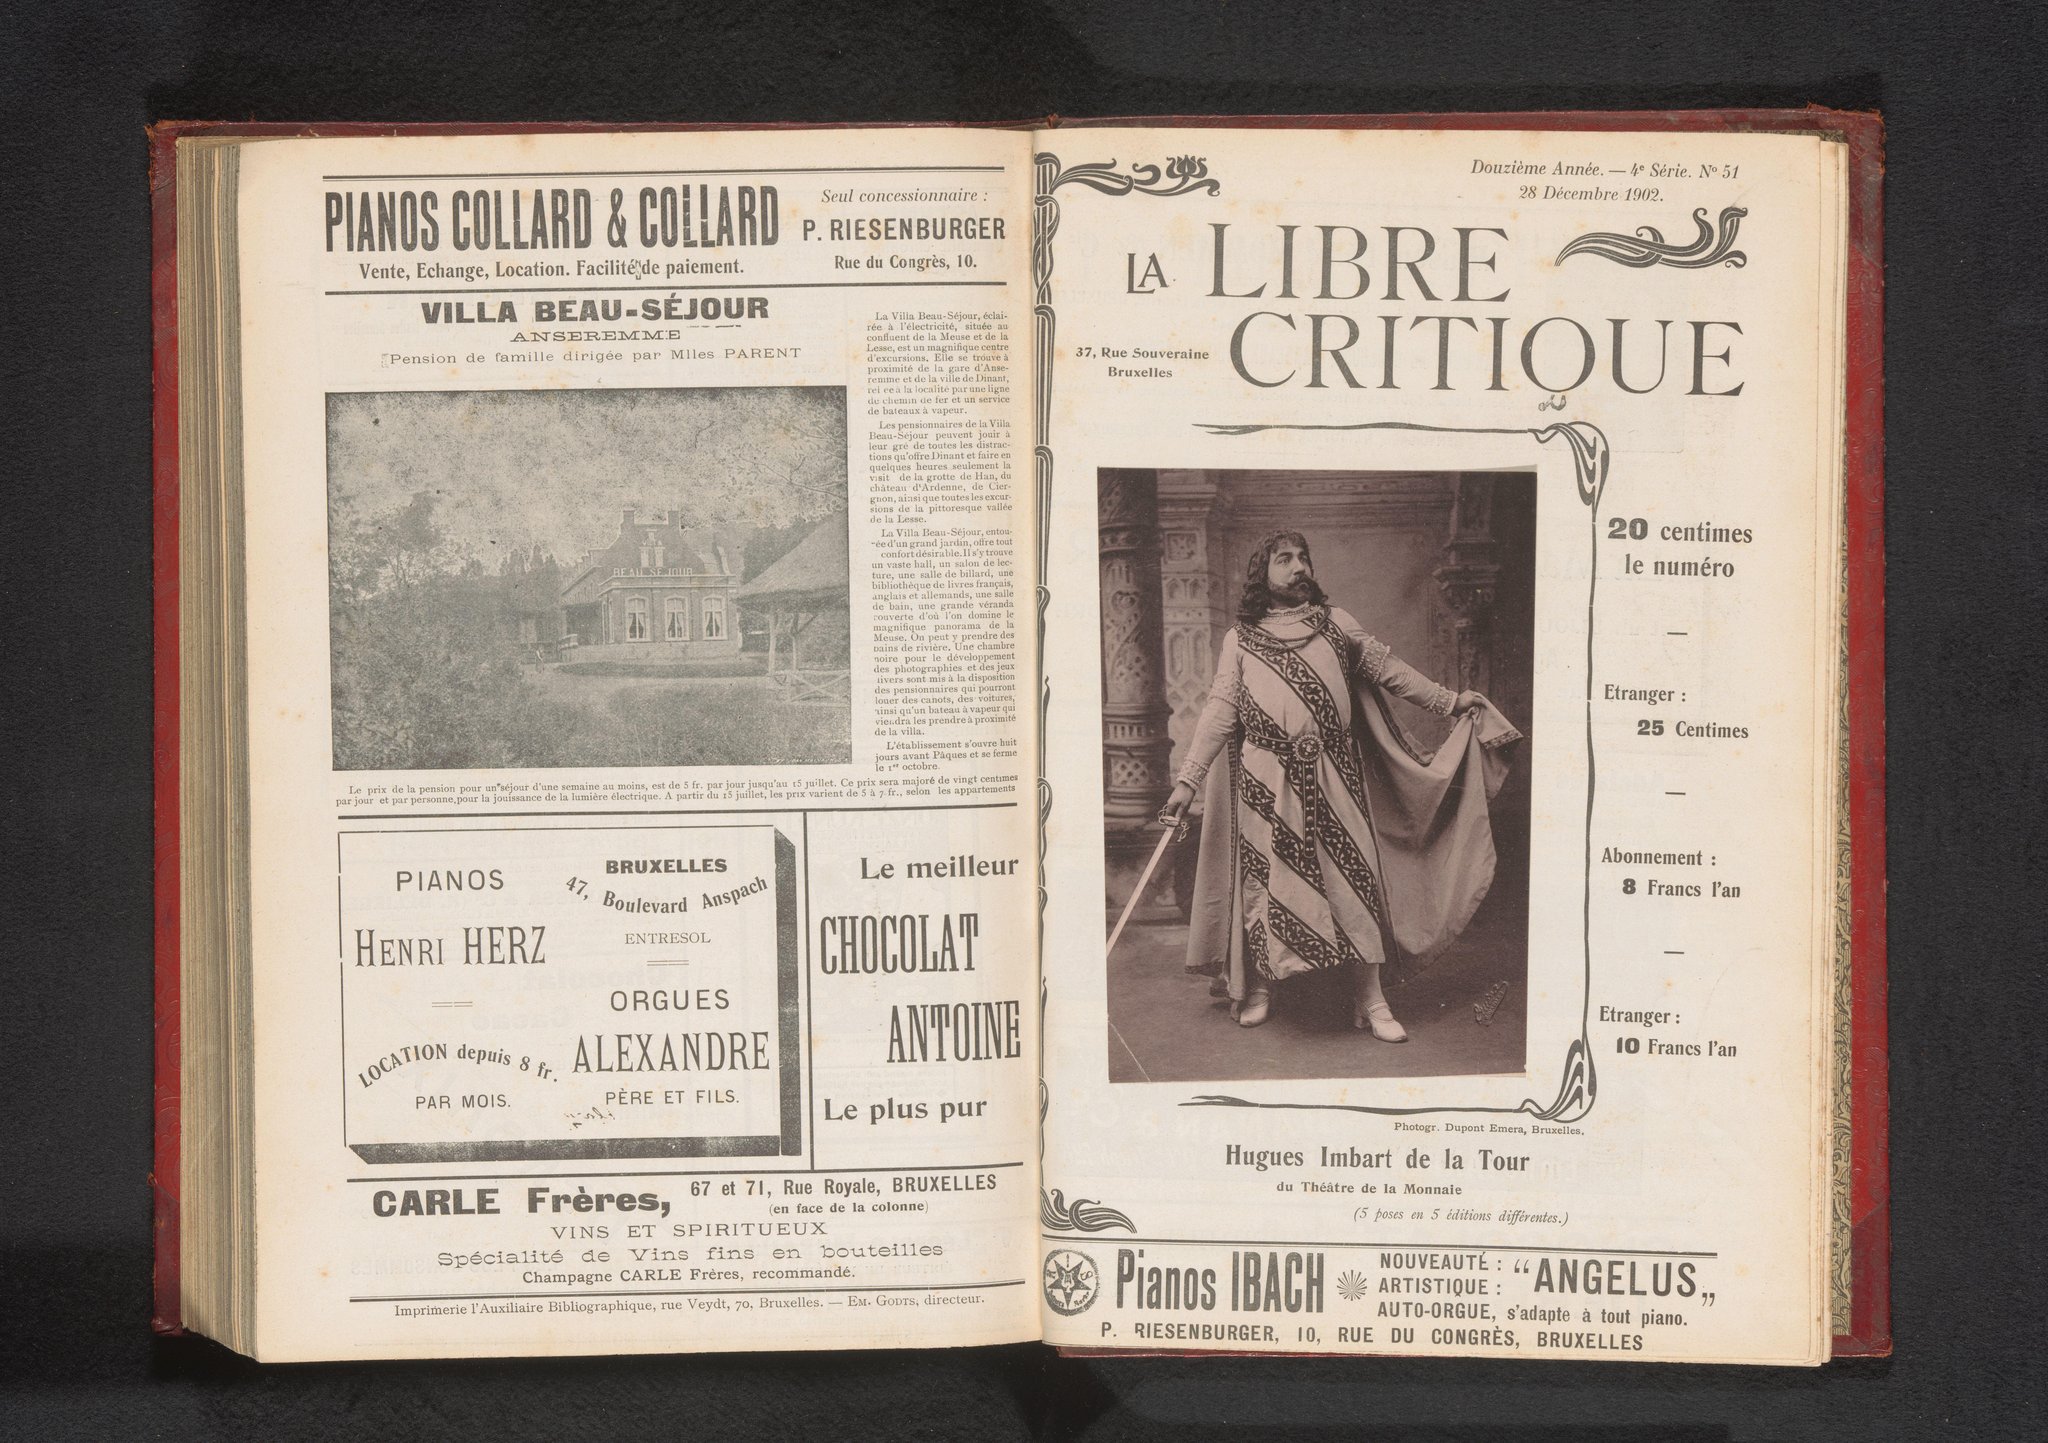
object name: page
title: Portret van Hugues Imbart de la Tour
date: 1897-1902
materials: paper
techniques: photograph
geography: brussels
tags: portrait of opera-singer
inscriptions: inscription: ‘du Théâtre de la Monnaie (5 poses en 5 éditions différentes)’